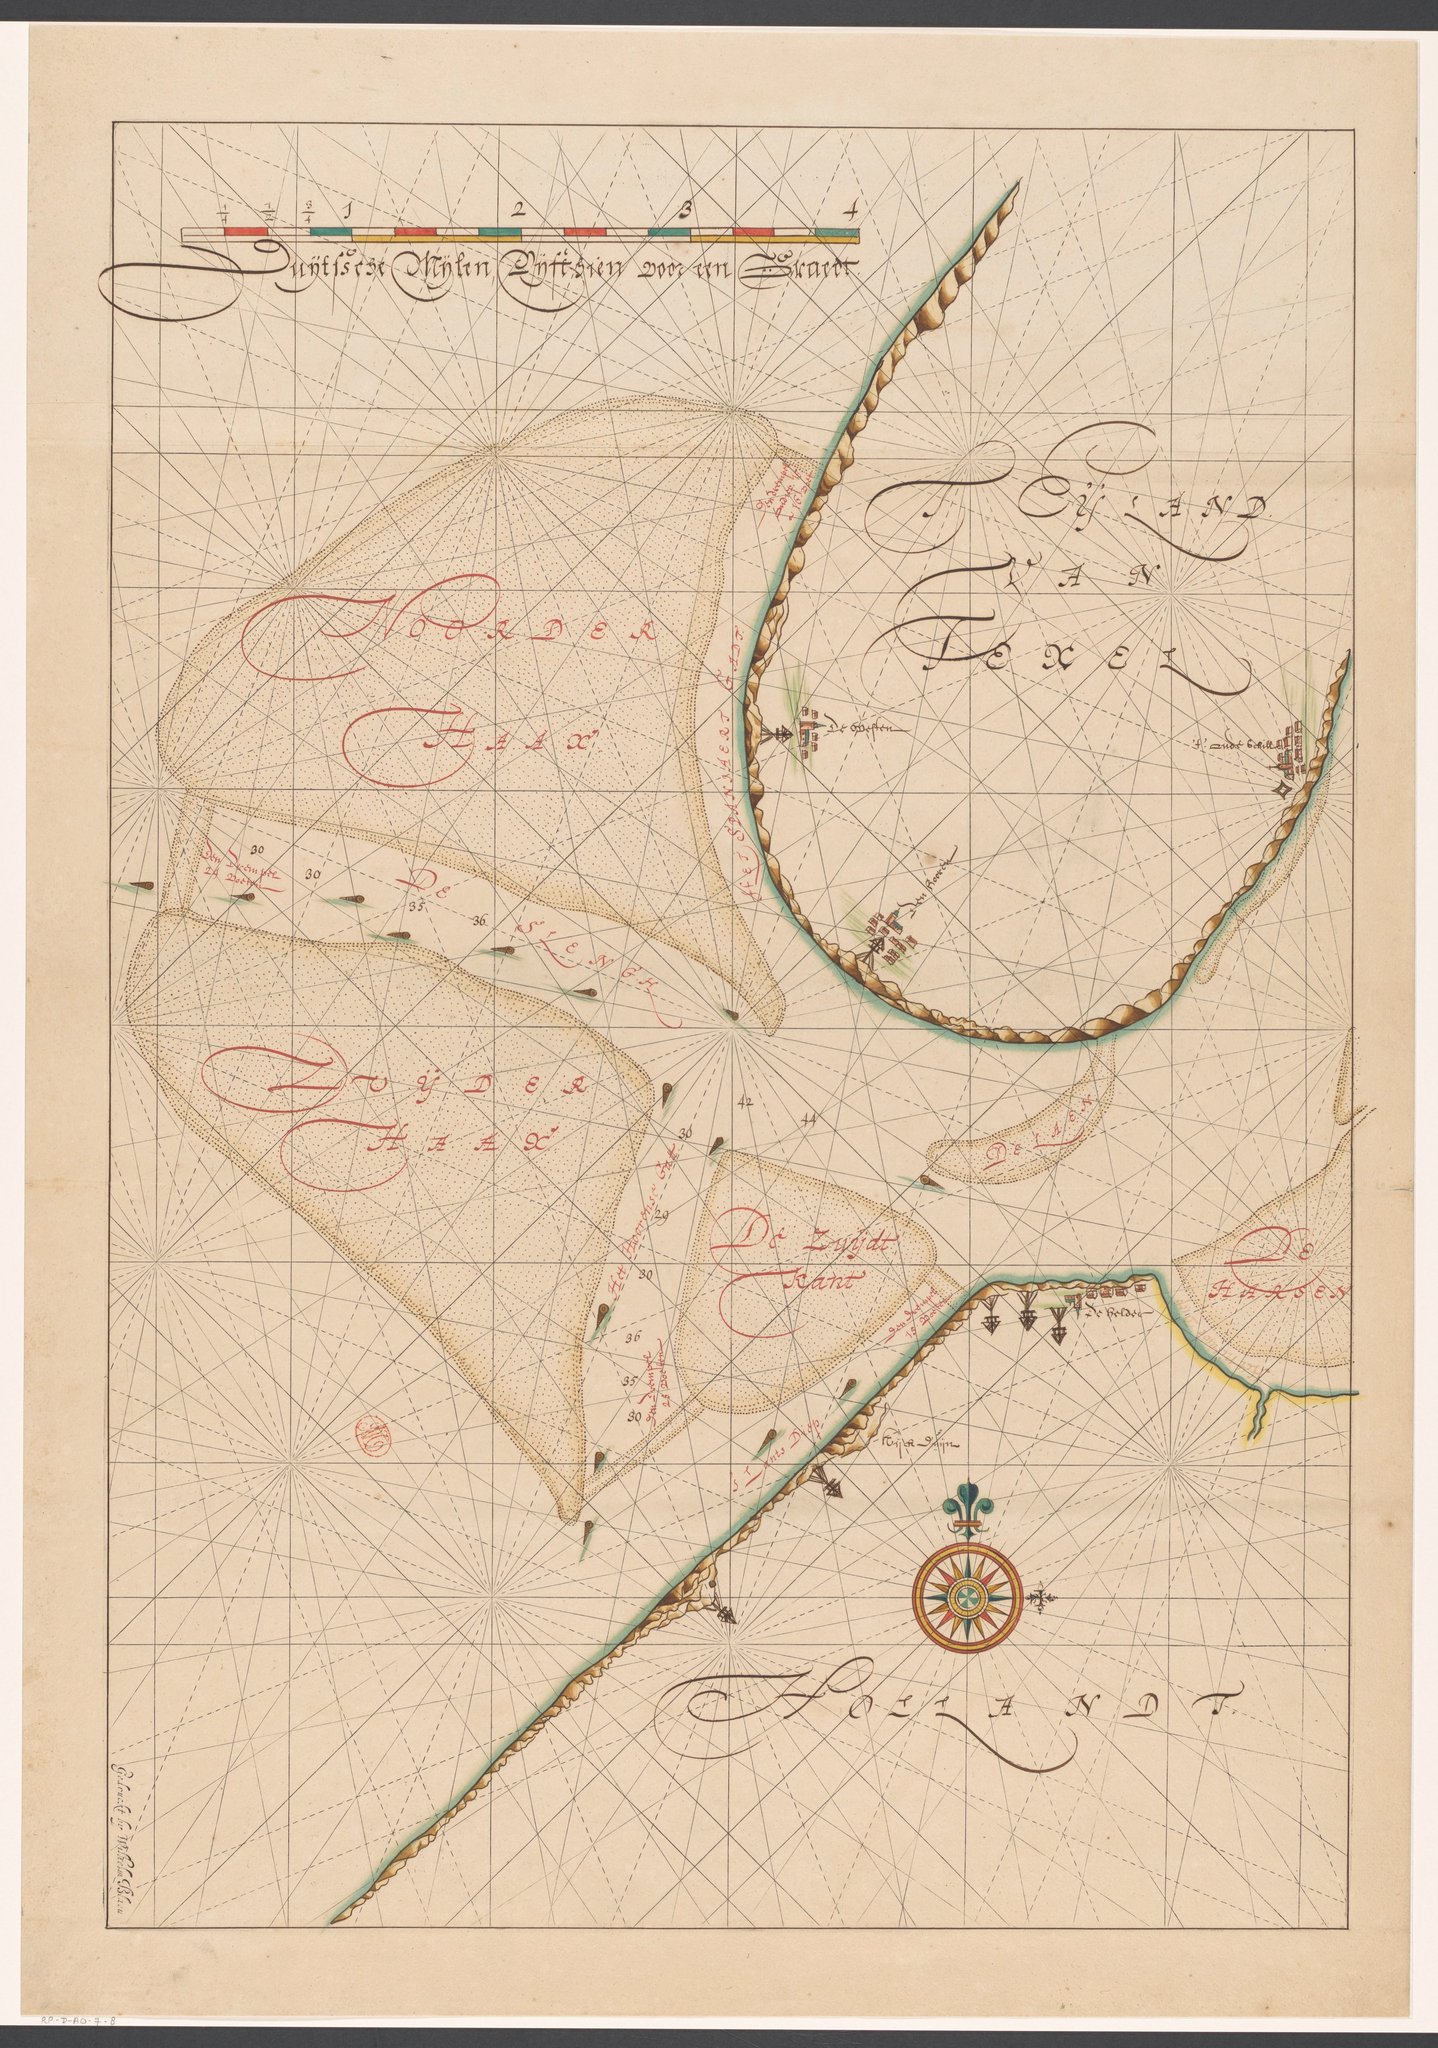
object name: map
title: Kaart van een deel van de Kop van Noord-Holland, Zuid-Texel en de omliggende zandbanken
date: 1620-1699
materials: ink, paper, watercolor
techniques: brush, engraving, pen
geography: amsterdam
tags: maps of separate countries or regions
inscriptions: collector's mark: Lugt 195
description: Manuscriptkaart op een gedrukt blad met gegraveerde kompaslijnen. Voor een soortgelijke kaart van Vlieland, Terschelling en Friesland, zie RP-P-AO-7-3.